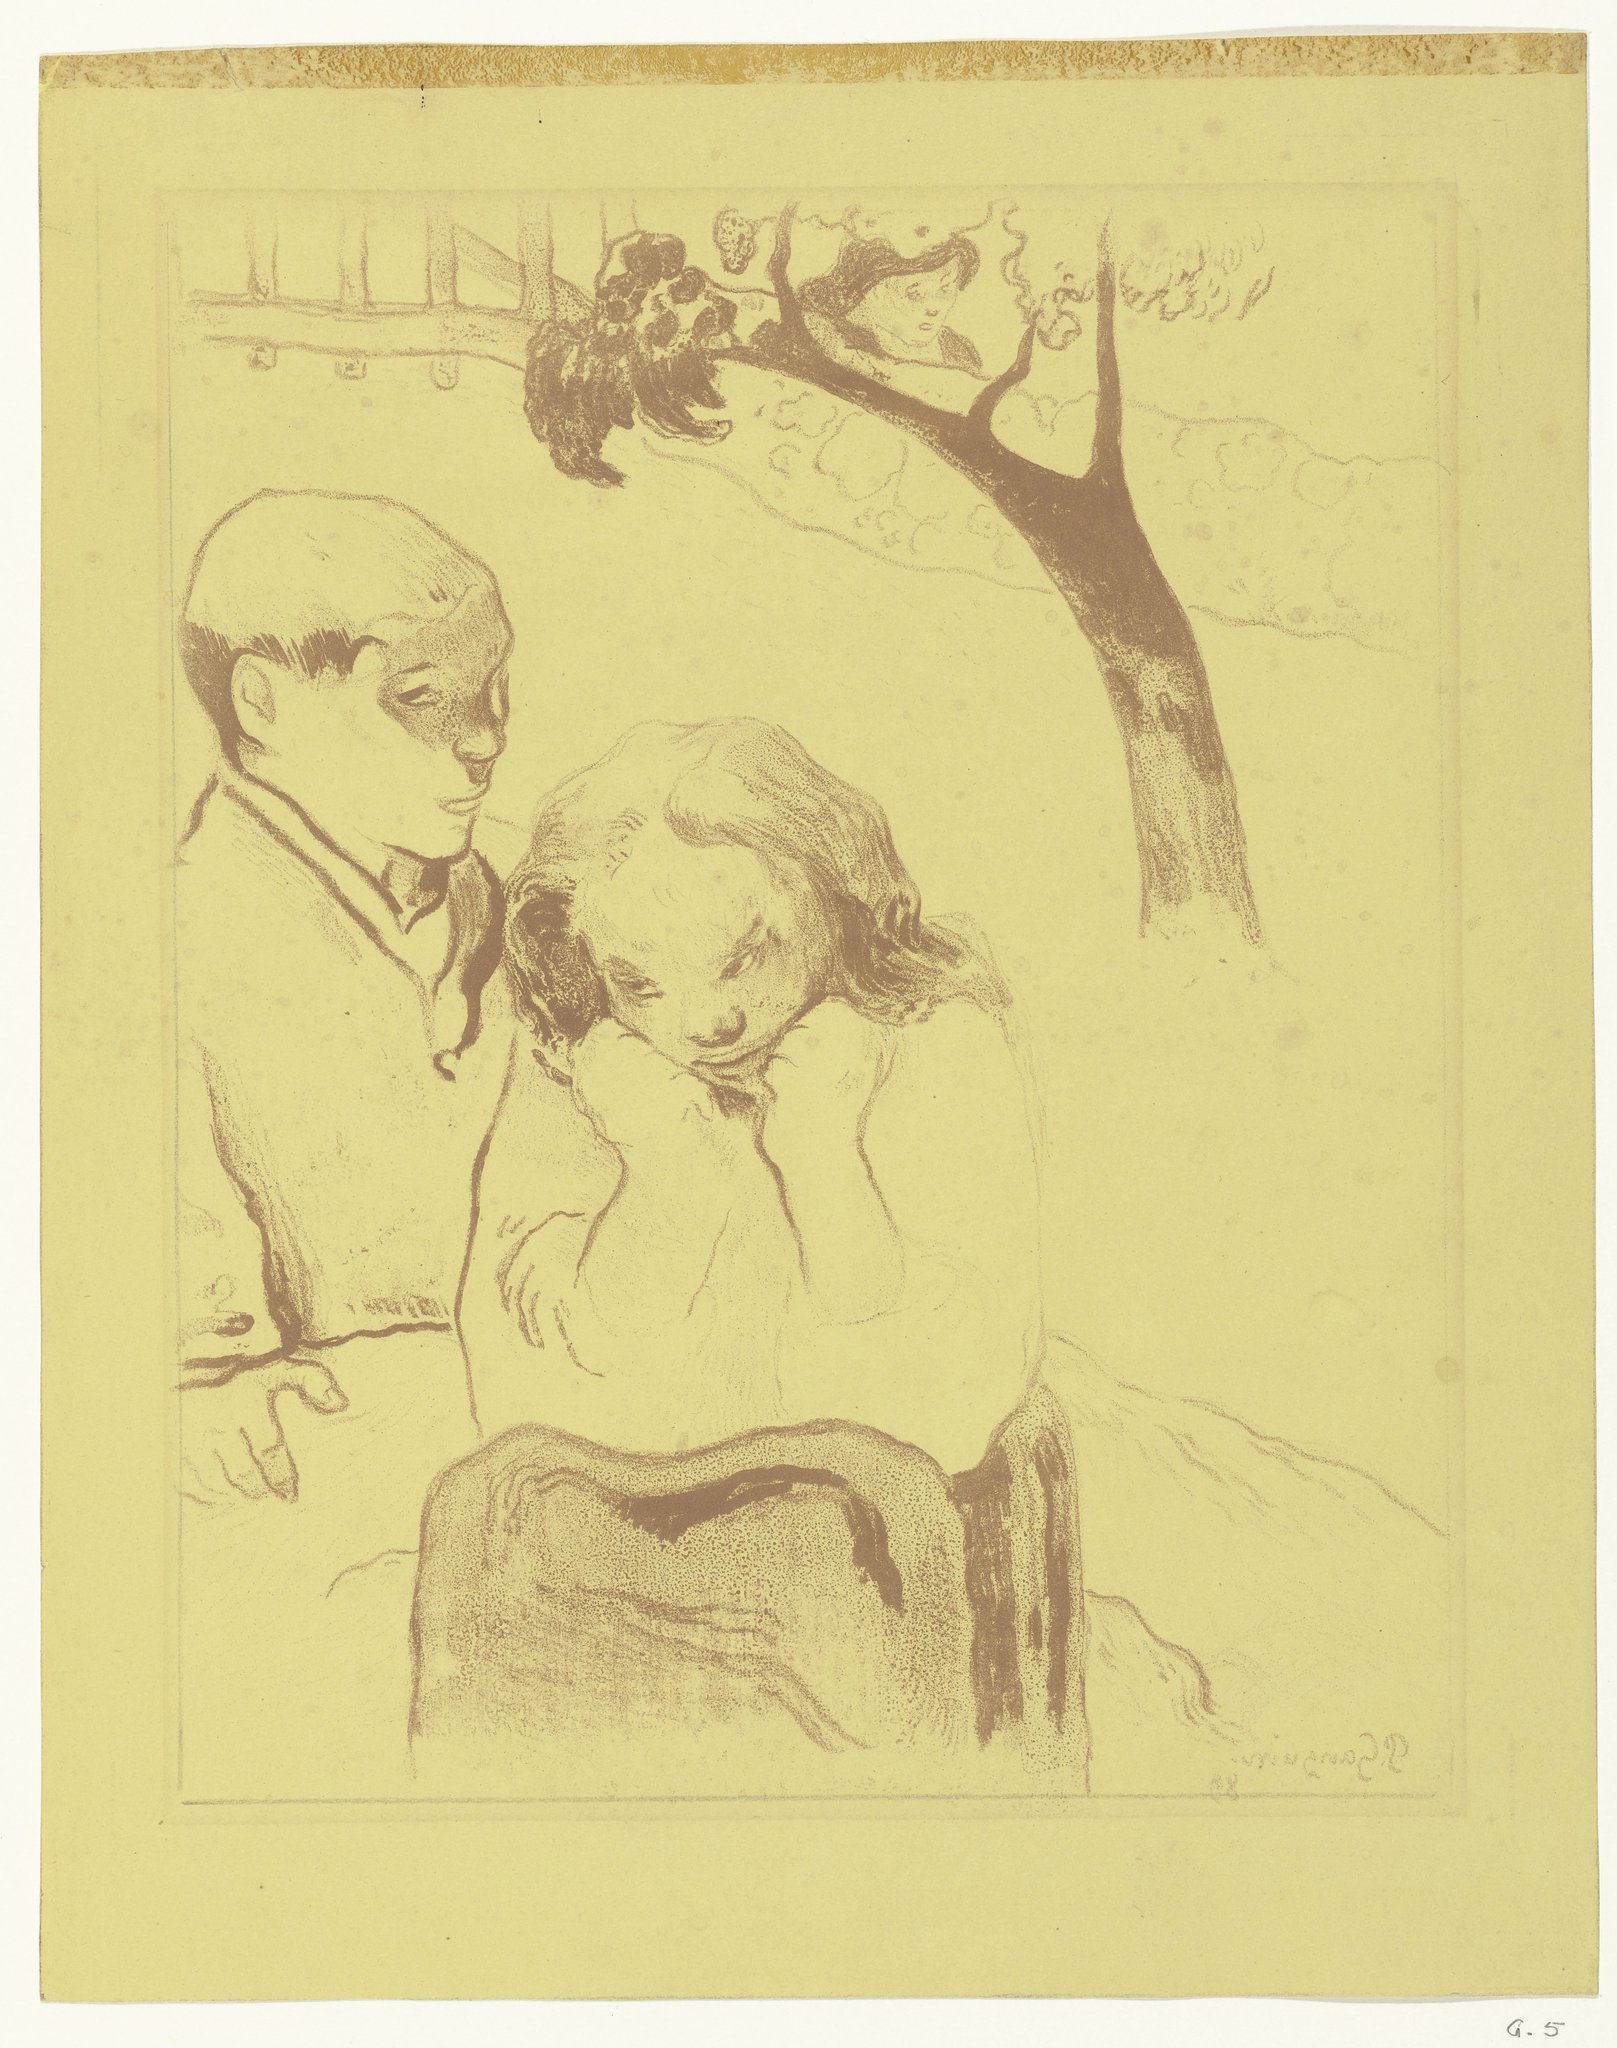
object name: print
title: Verdrietige vrouw zit bij een man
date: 1889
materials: paper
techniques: printing, lithography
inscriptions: collector's mark: Lugt 2228, collector's mark: Lugt 2760